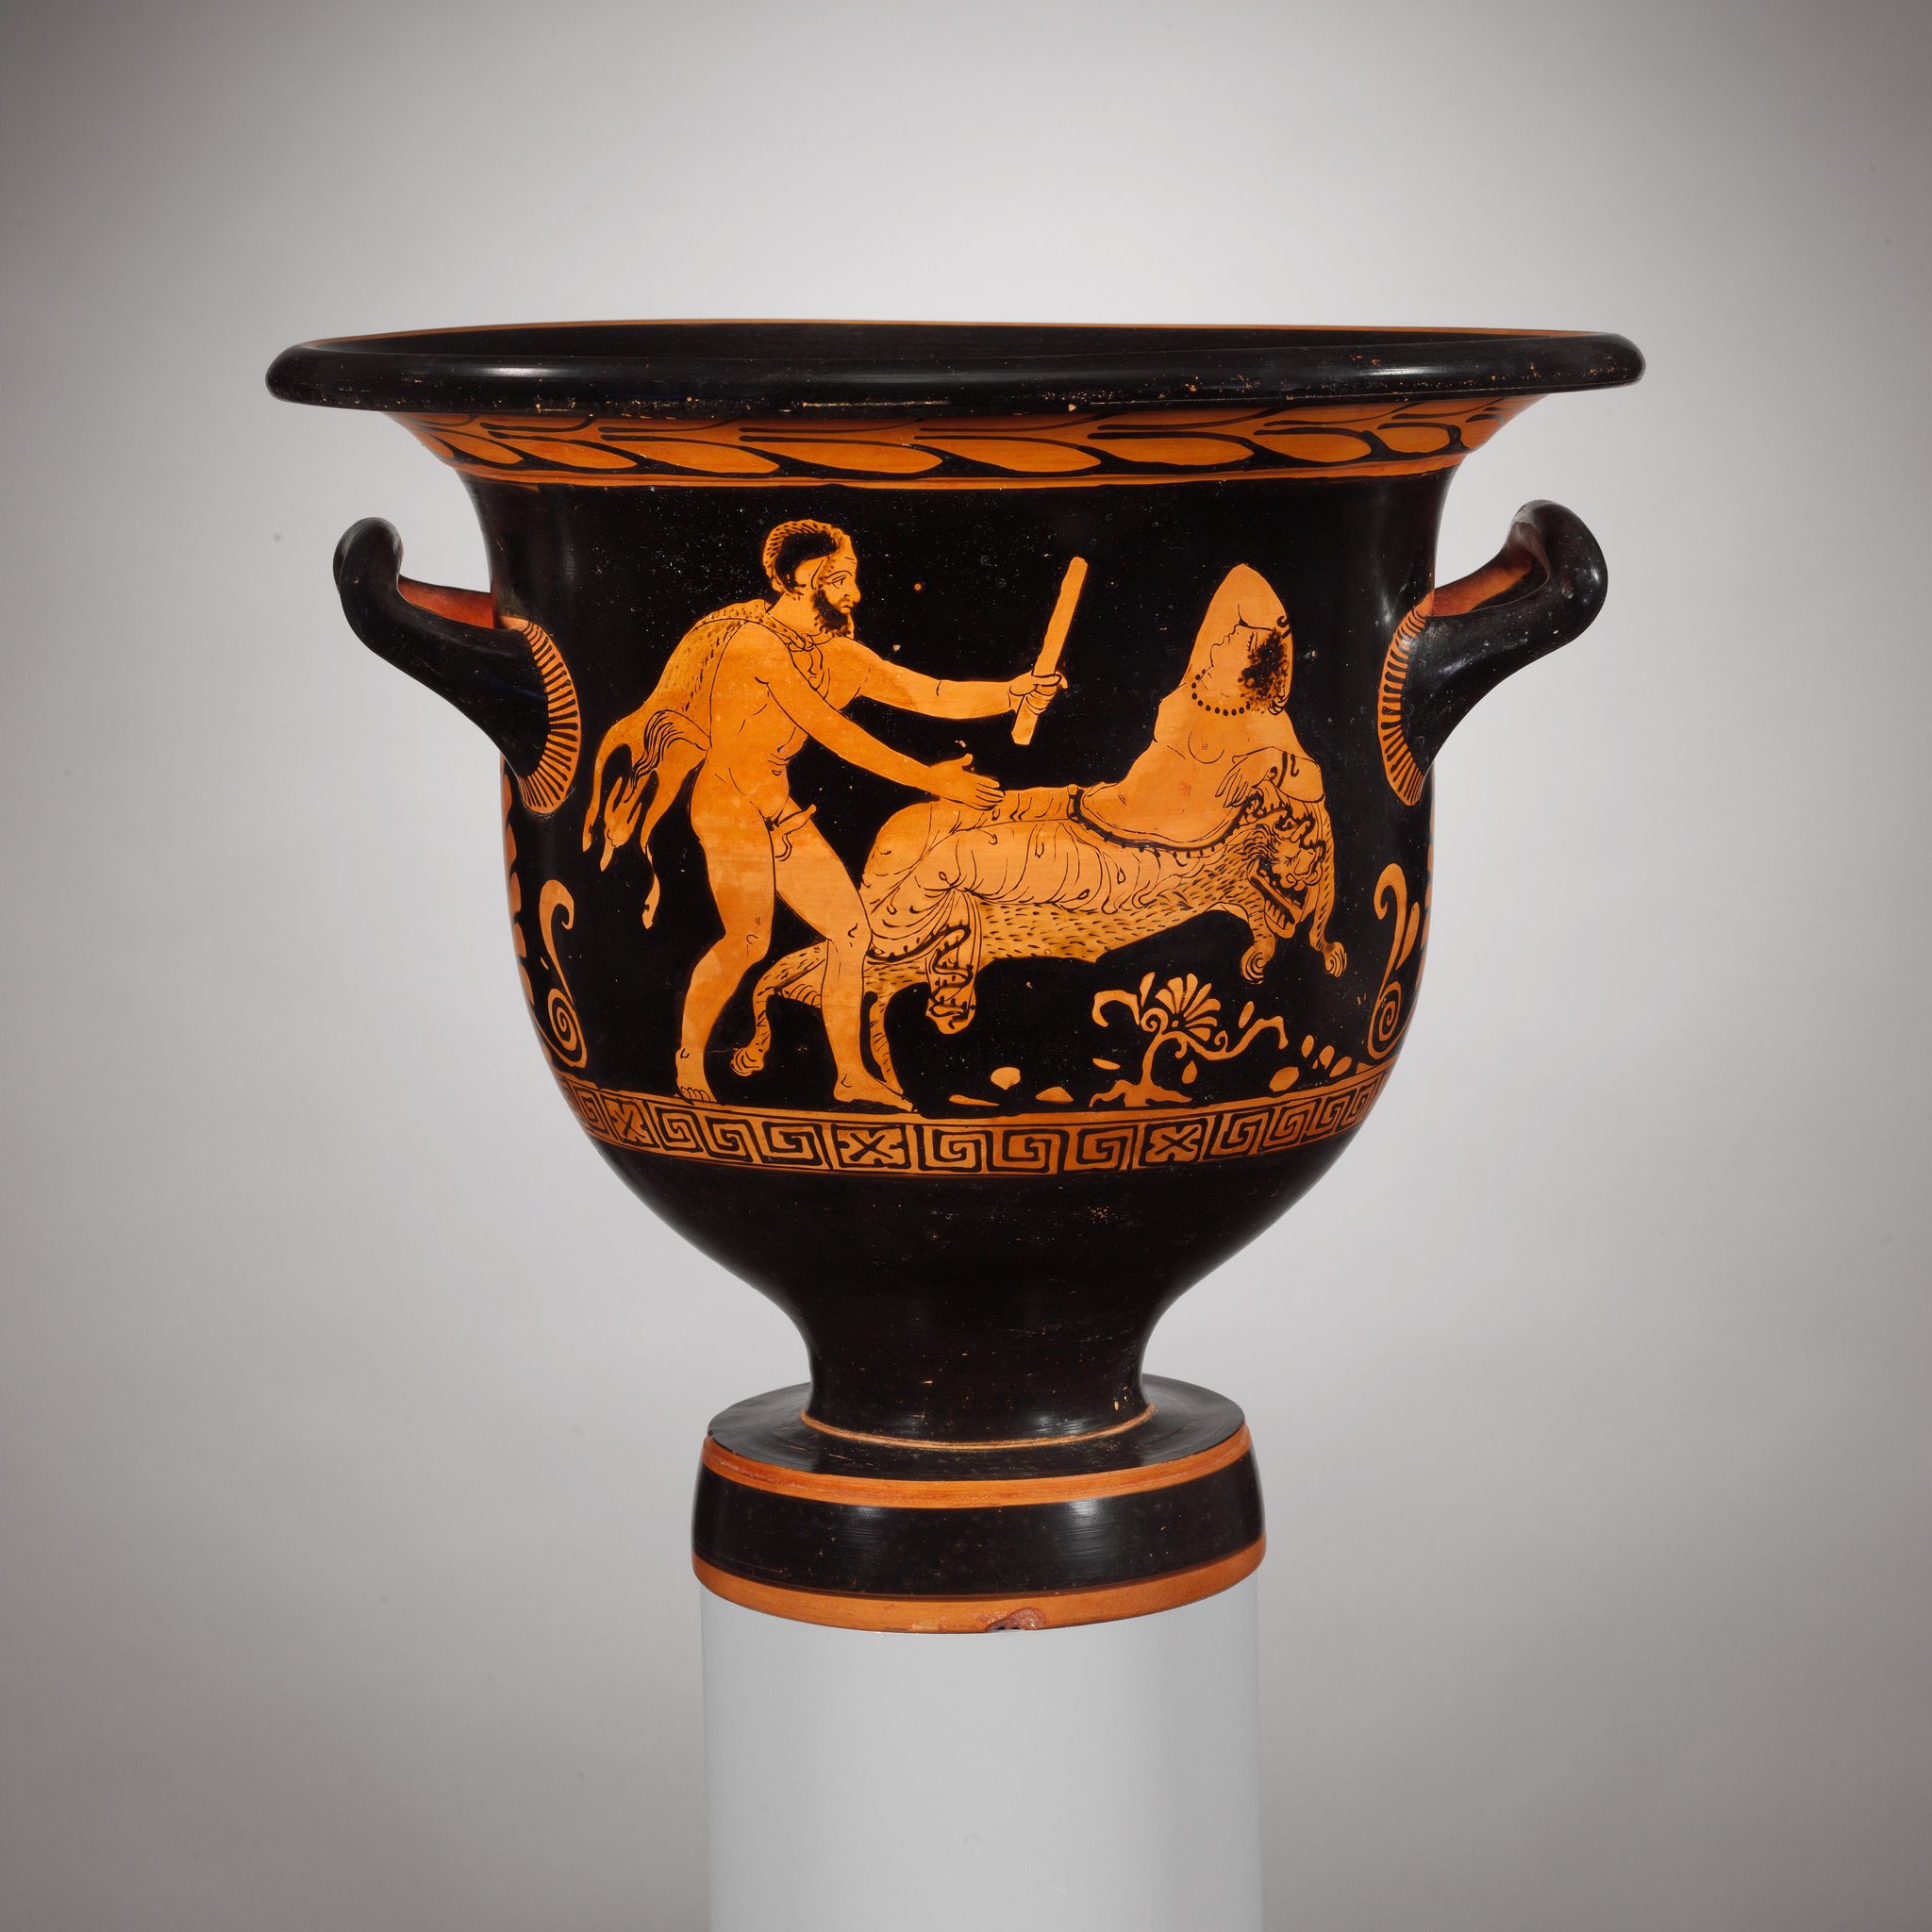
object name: bell krater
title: Terracotta bell-krater (mixing bowl)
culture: greek, south italian, apulian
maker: painter of the long overfalls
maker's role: artist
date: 380-360 BCE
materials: terracotta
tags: men,maenads,satyrs